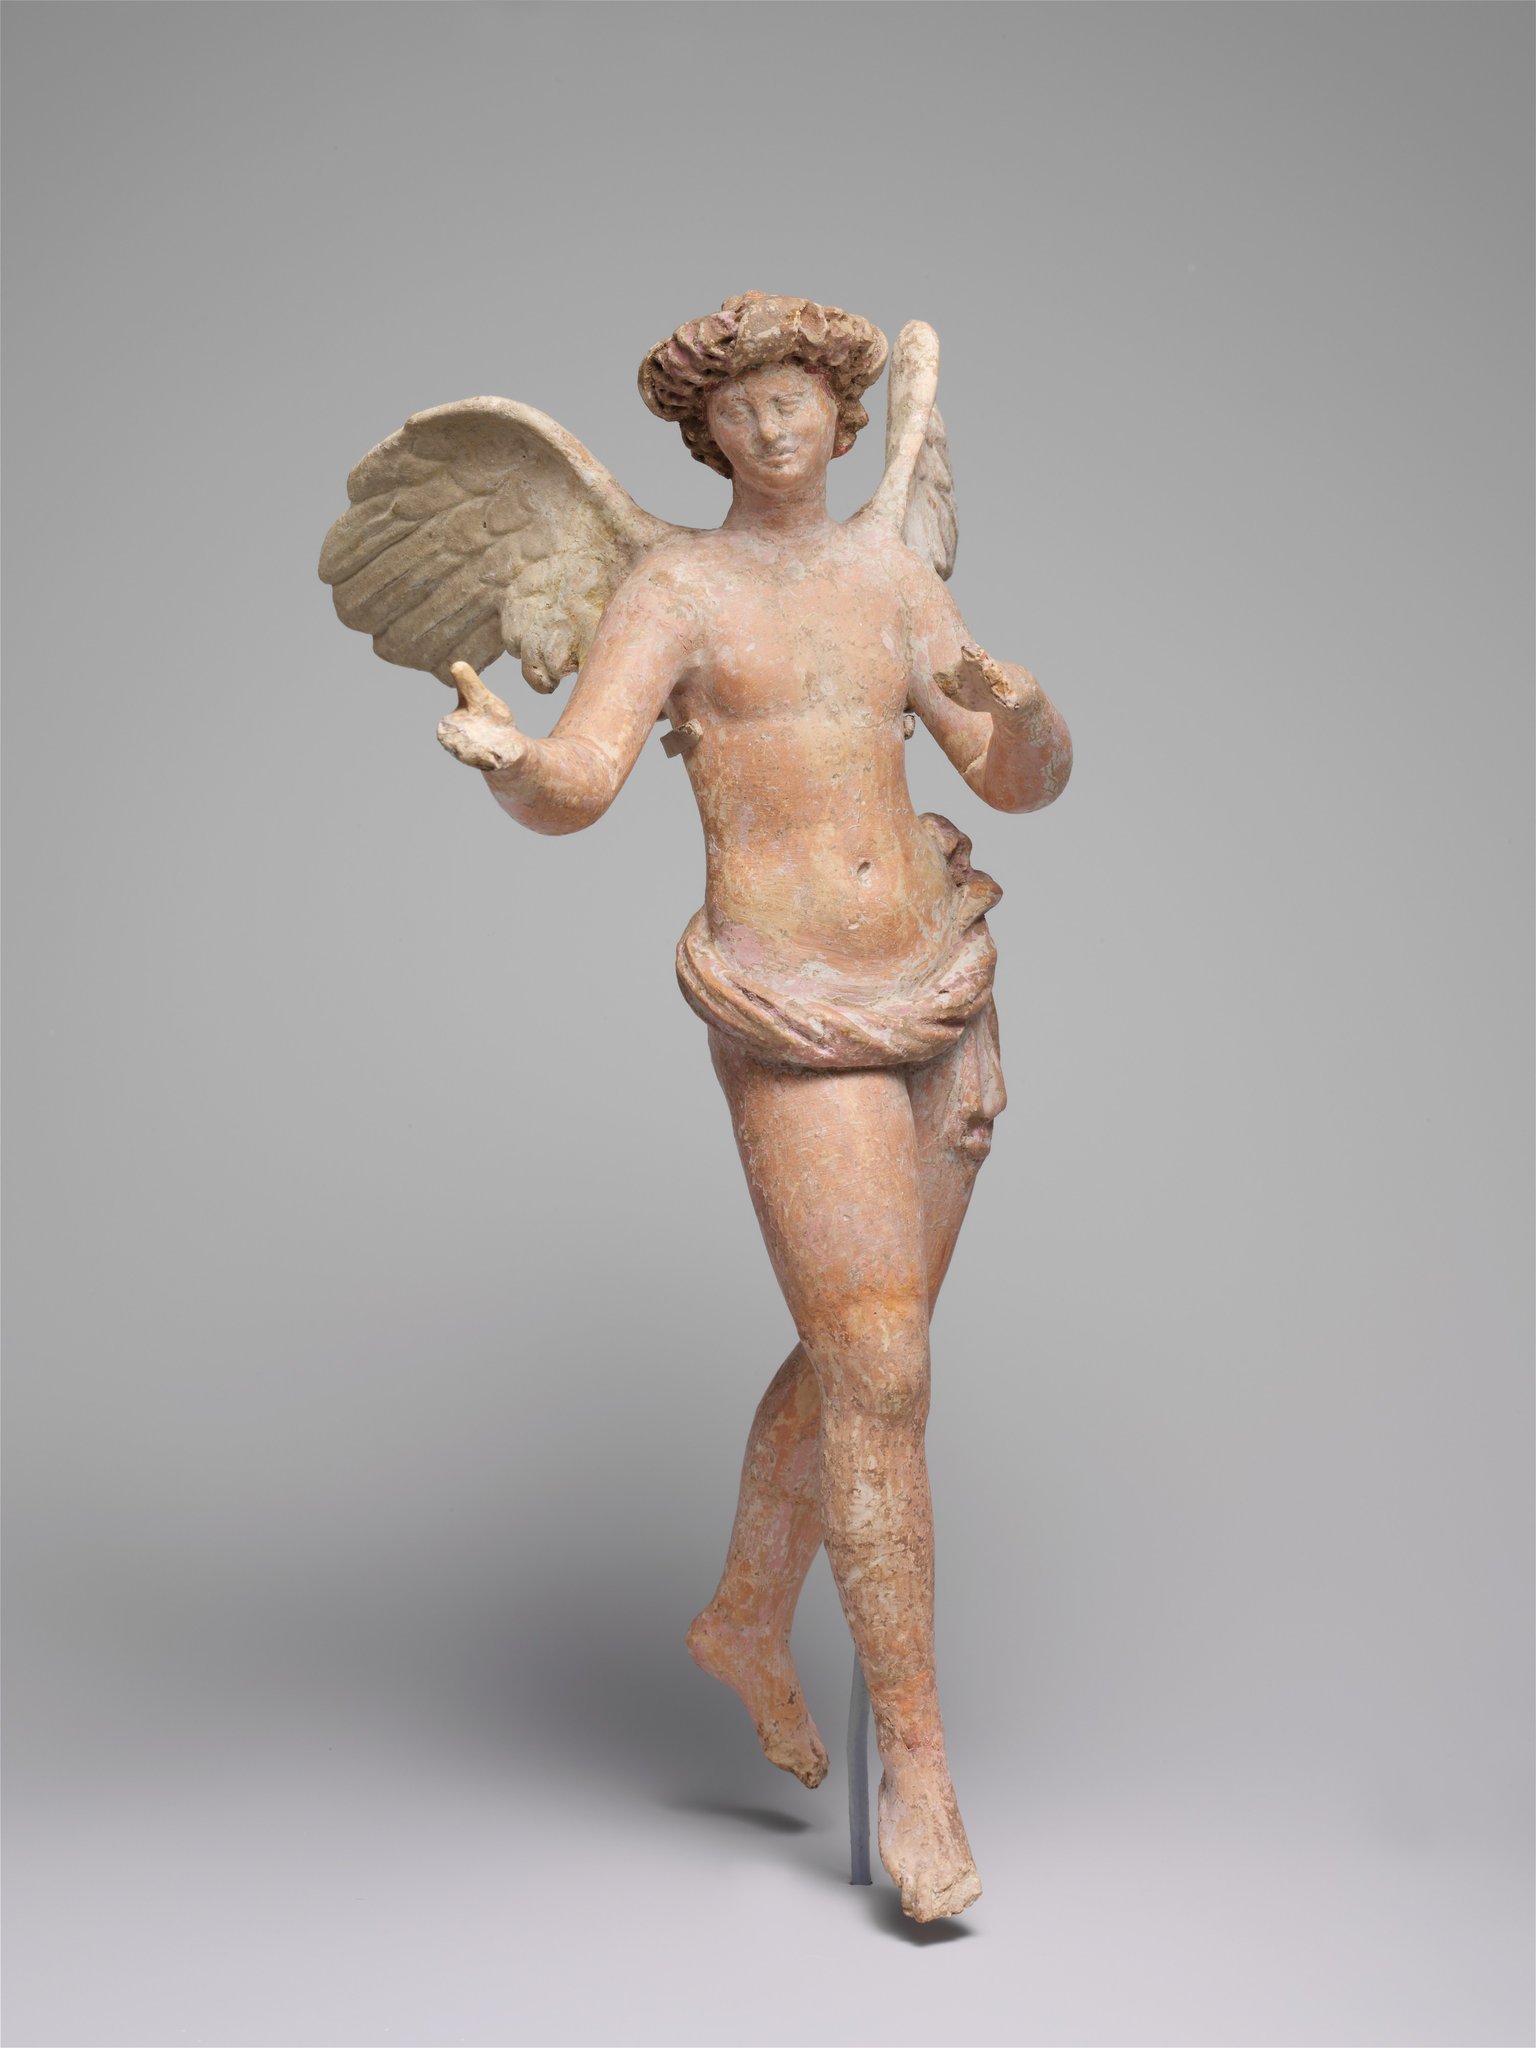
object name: statuette of eros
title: Terracotta statuette of Eros flying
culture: greek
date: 200-150 BCE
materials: terracotta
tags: eros